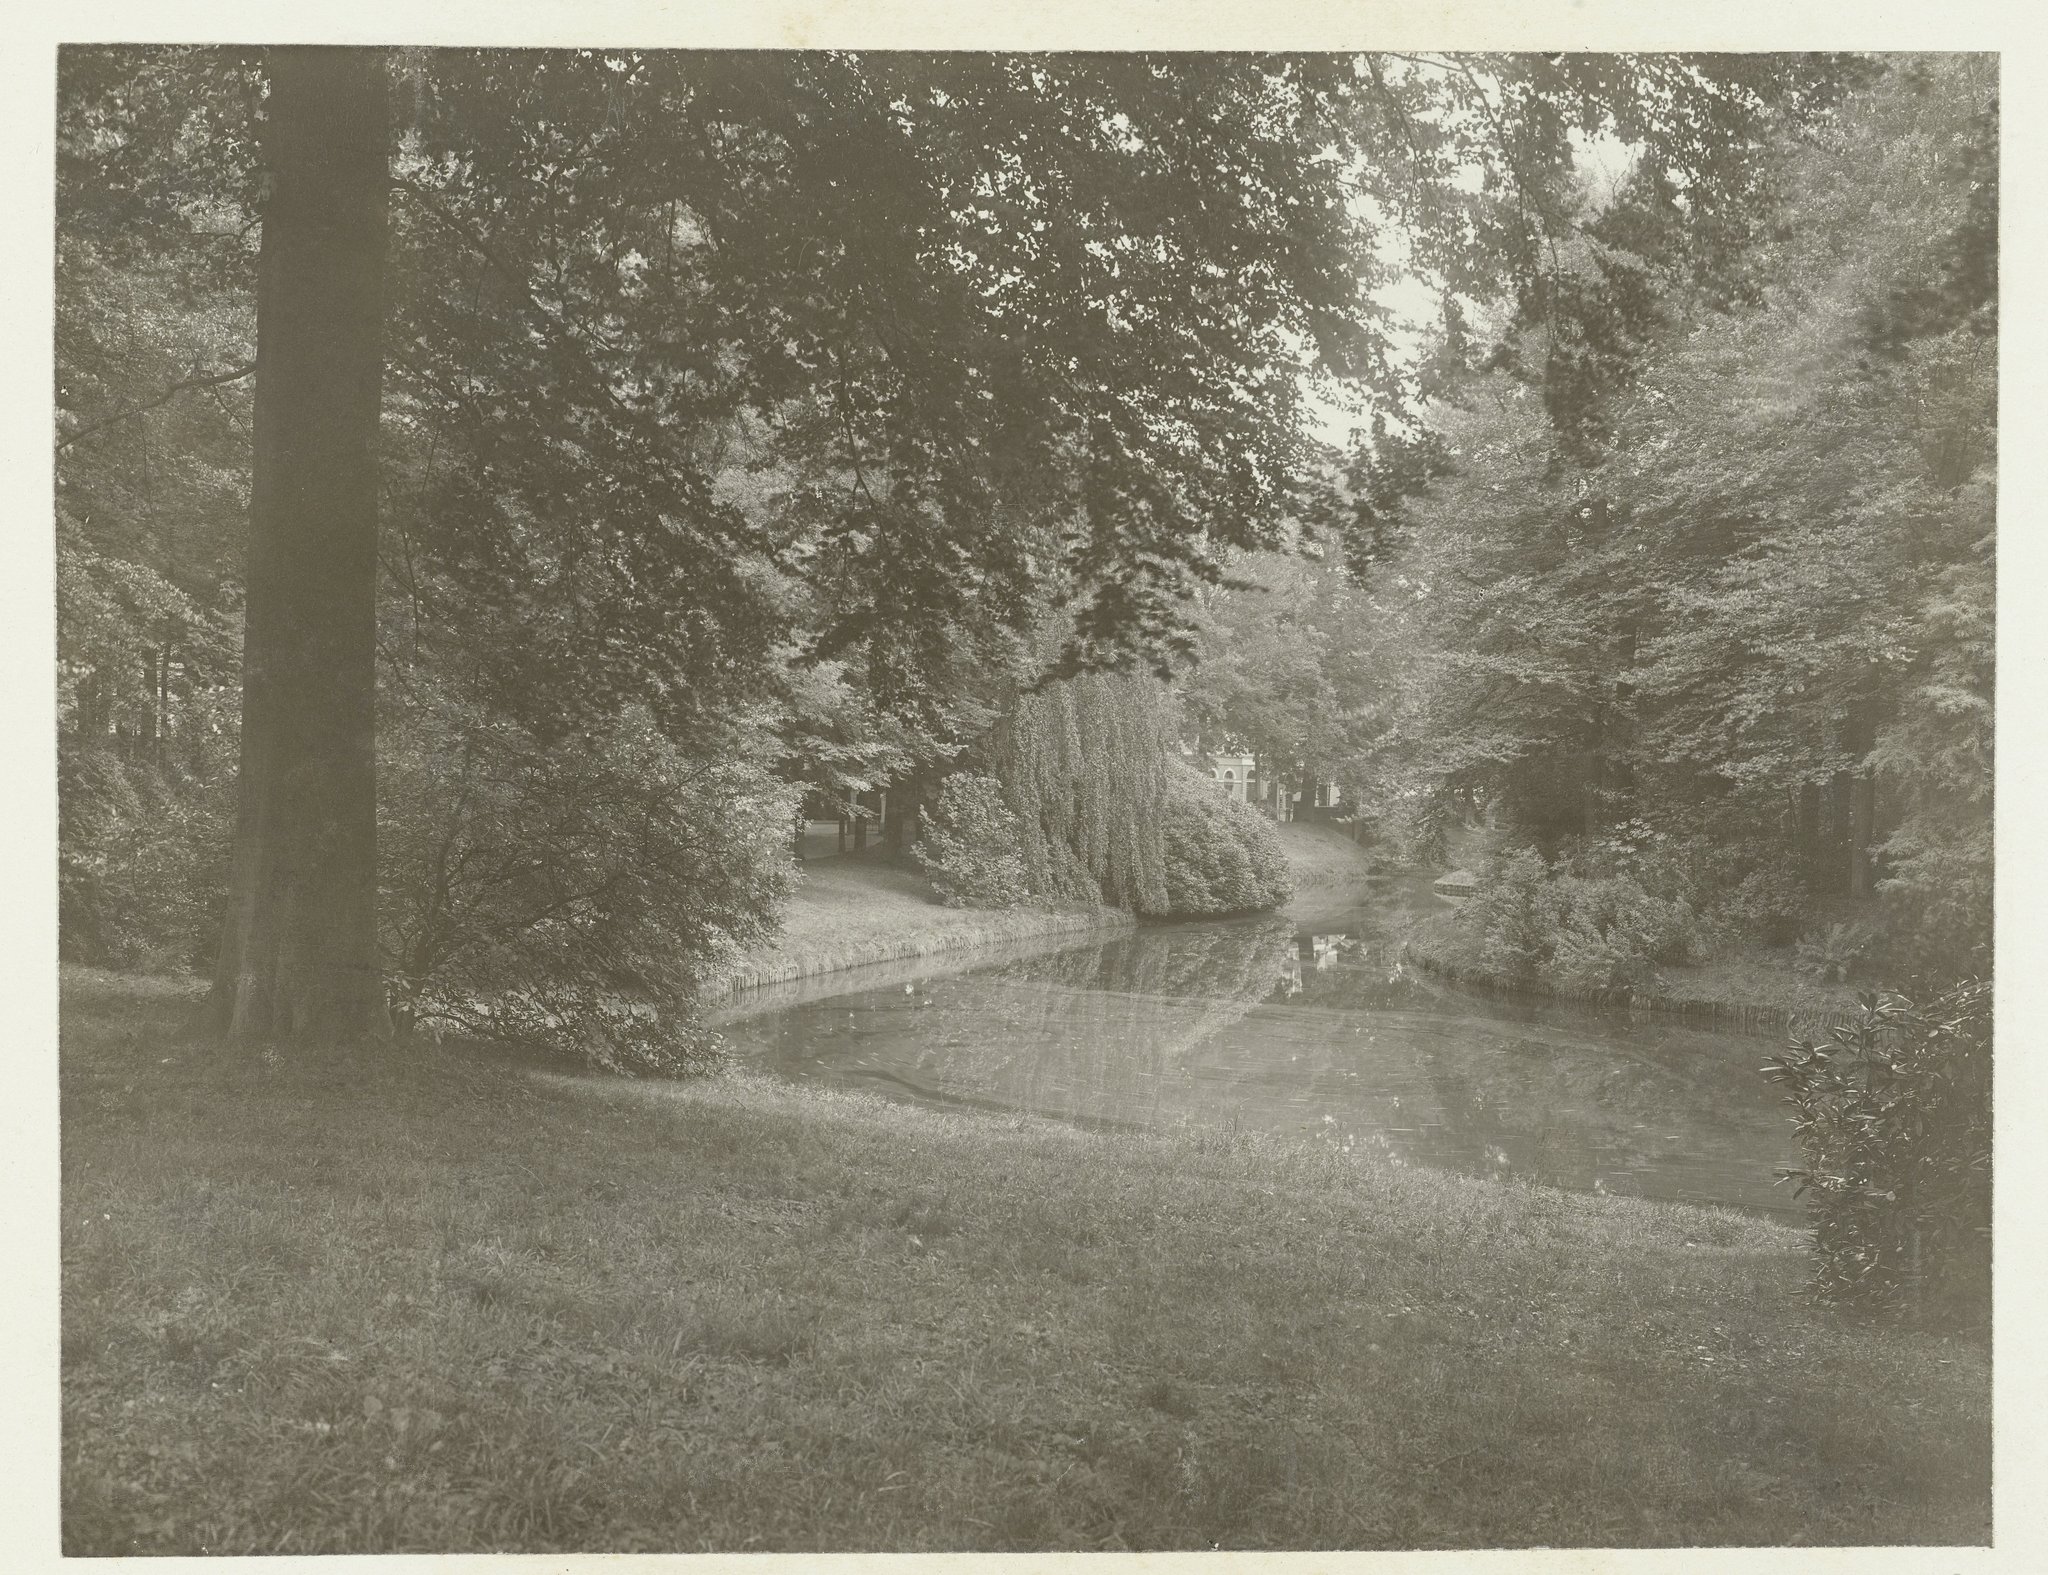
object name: photograph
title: De tuin en het water behorend bij landhuis de Wildbaan, Driebergen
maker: henry pauw van wieldrecht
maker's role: fotograaf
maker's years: 1863-1912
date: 1903-1907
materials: paper, photographic support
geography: netherlands